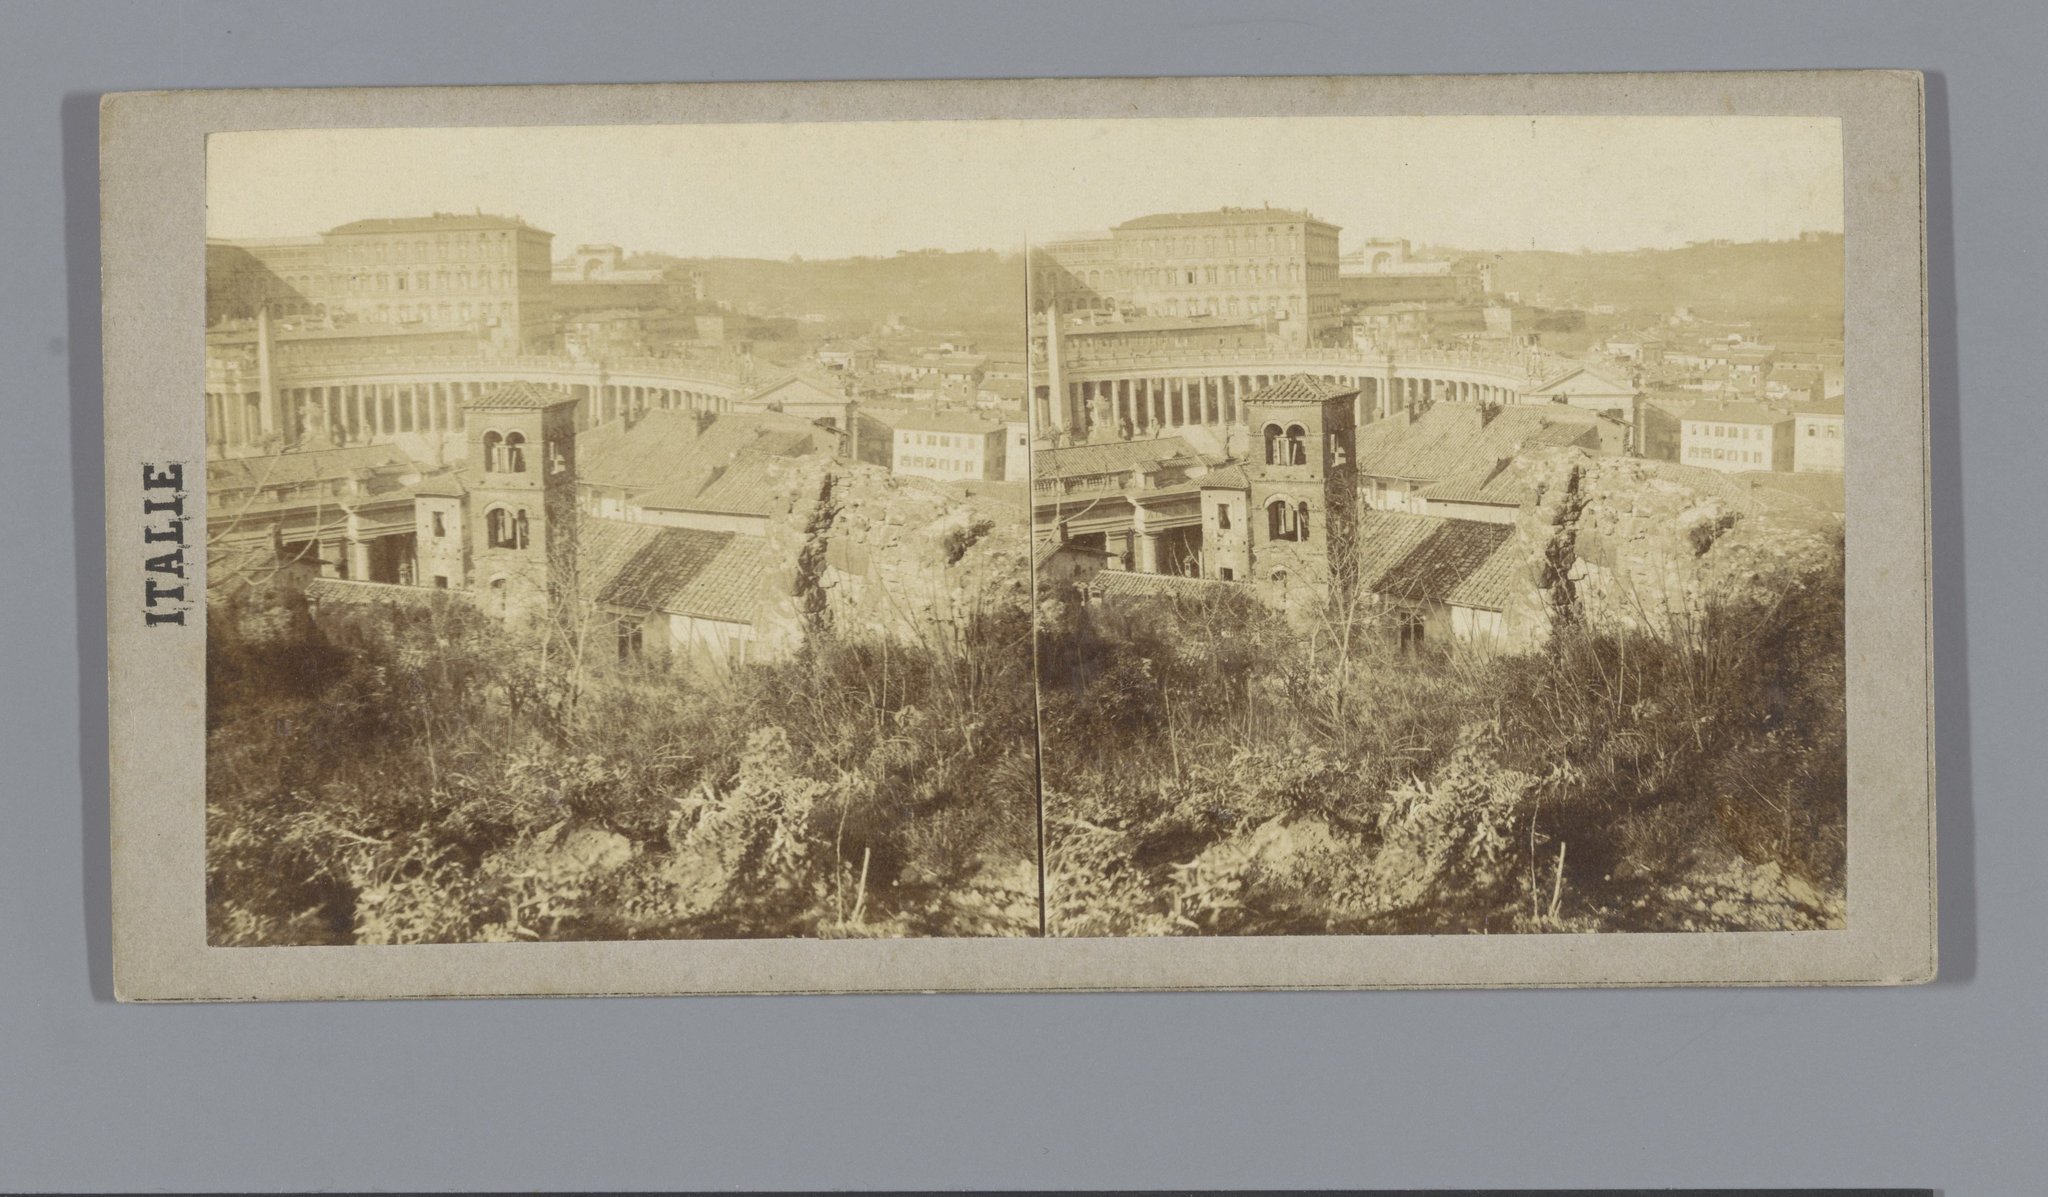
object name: stereograph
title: Gezicht op Vaticaanstad, gezien vanaf de Janiculum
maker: Anonymous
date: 1857-1859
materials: cardboard, photographic support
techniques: albumen print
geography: janiculum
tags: city-view in general; 'veduta'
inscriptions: inscription: ‘Les ruines du premier plan (...) Au fond la colonnade et la basilique de Saint-Pierre.’, name: ‘Kunsthandlung von Joh. Heinrigs CÖLN. Hochstrasse 152.’, number: ‘No 118.’, inscription: ‘ITALIE’